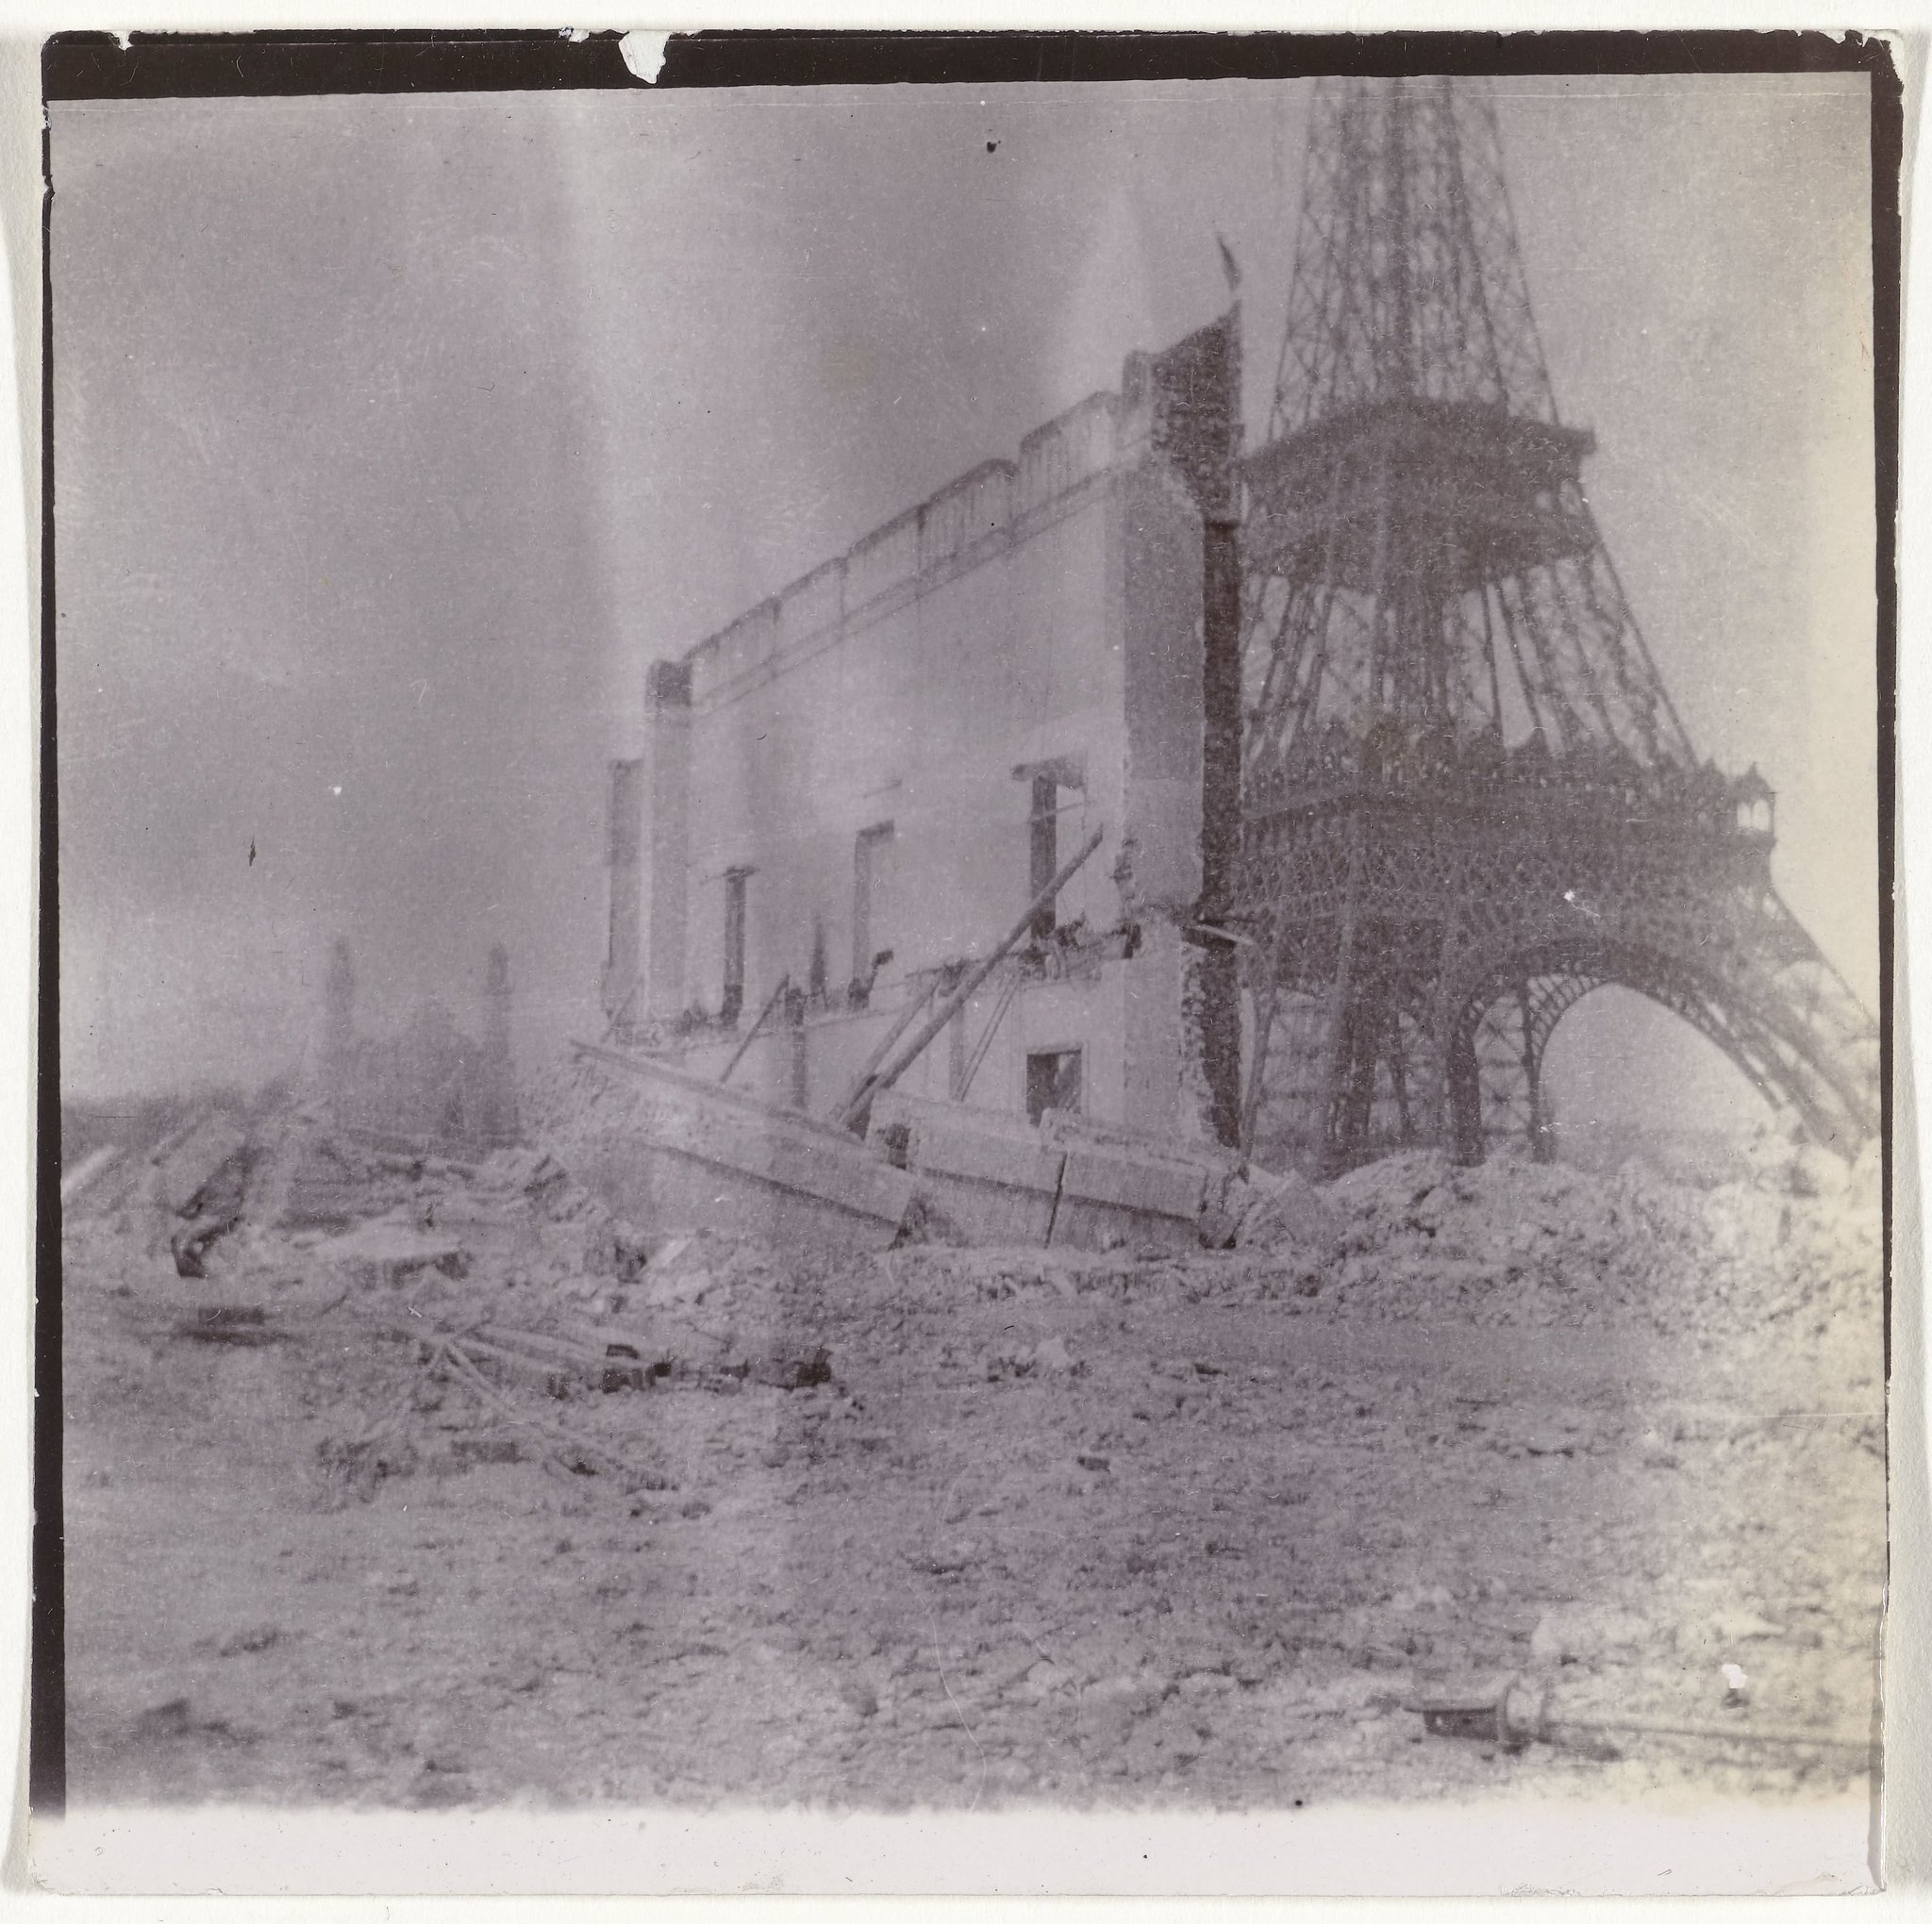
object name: photograph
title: Bouw van paviljoens naast de Eiffeltoren voor de Wereldtentoonstelling van 1889 in Parijs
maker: Anonymous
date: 1889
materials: paper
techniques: collodion silver print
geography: paris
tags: tower, clock tower ~ monumental adornment, building-site, paris, eiffel tower